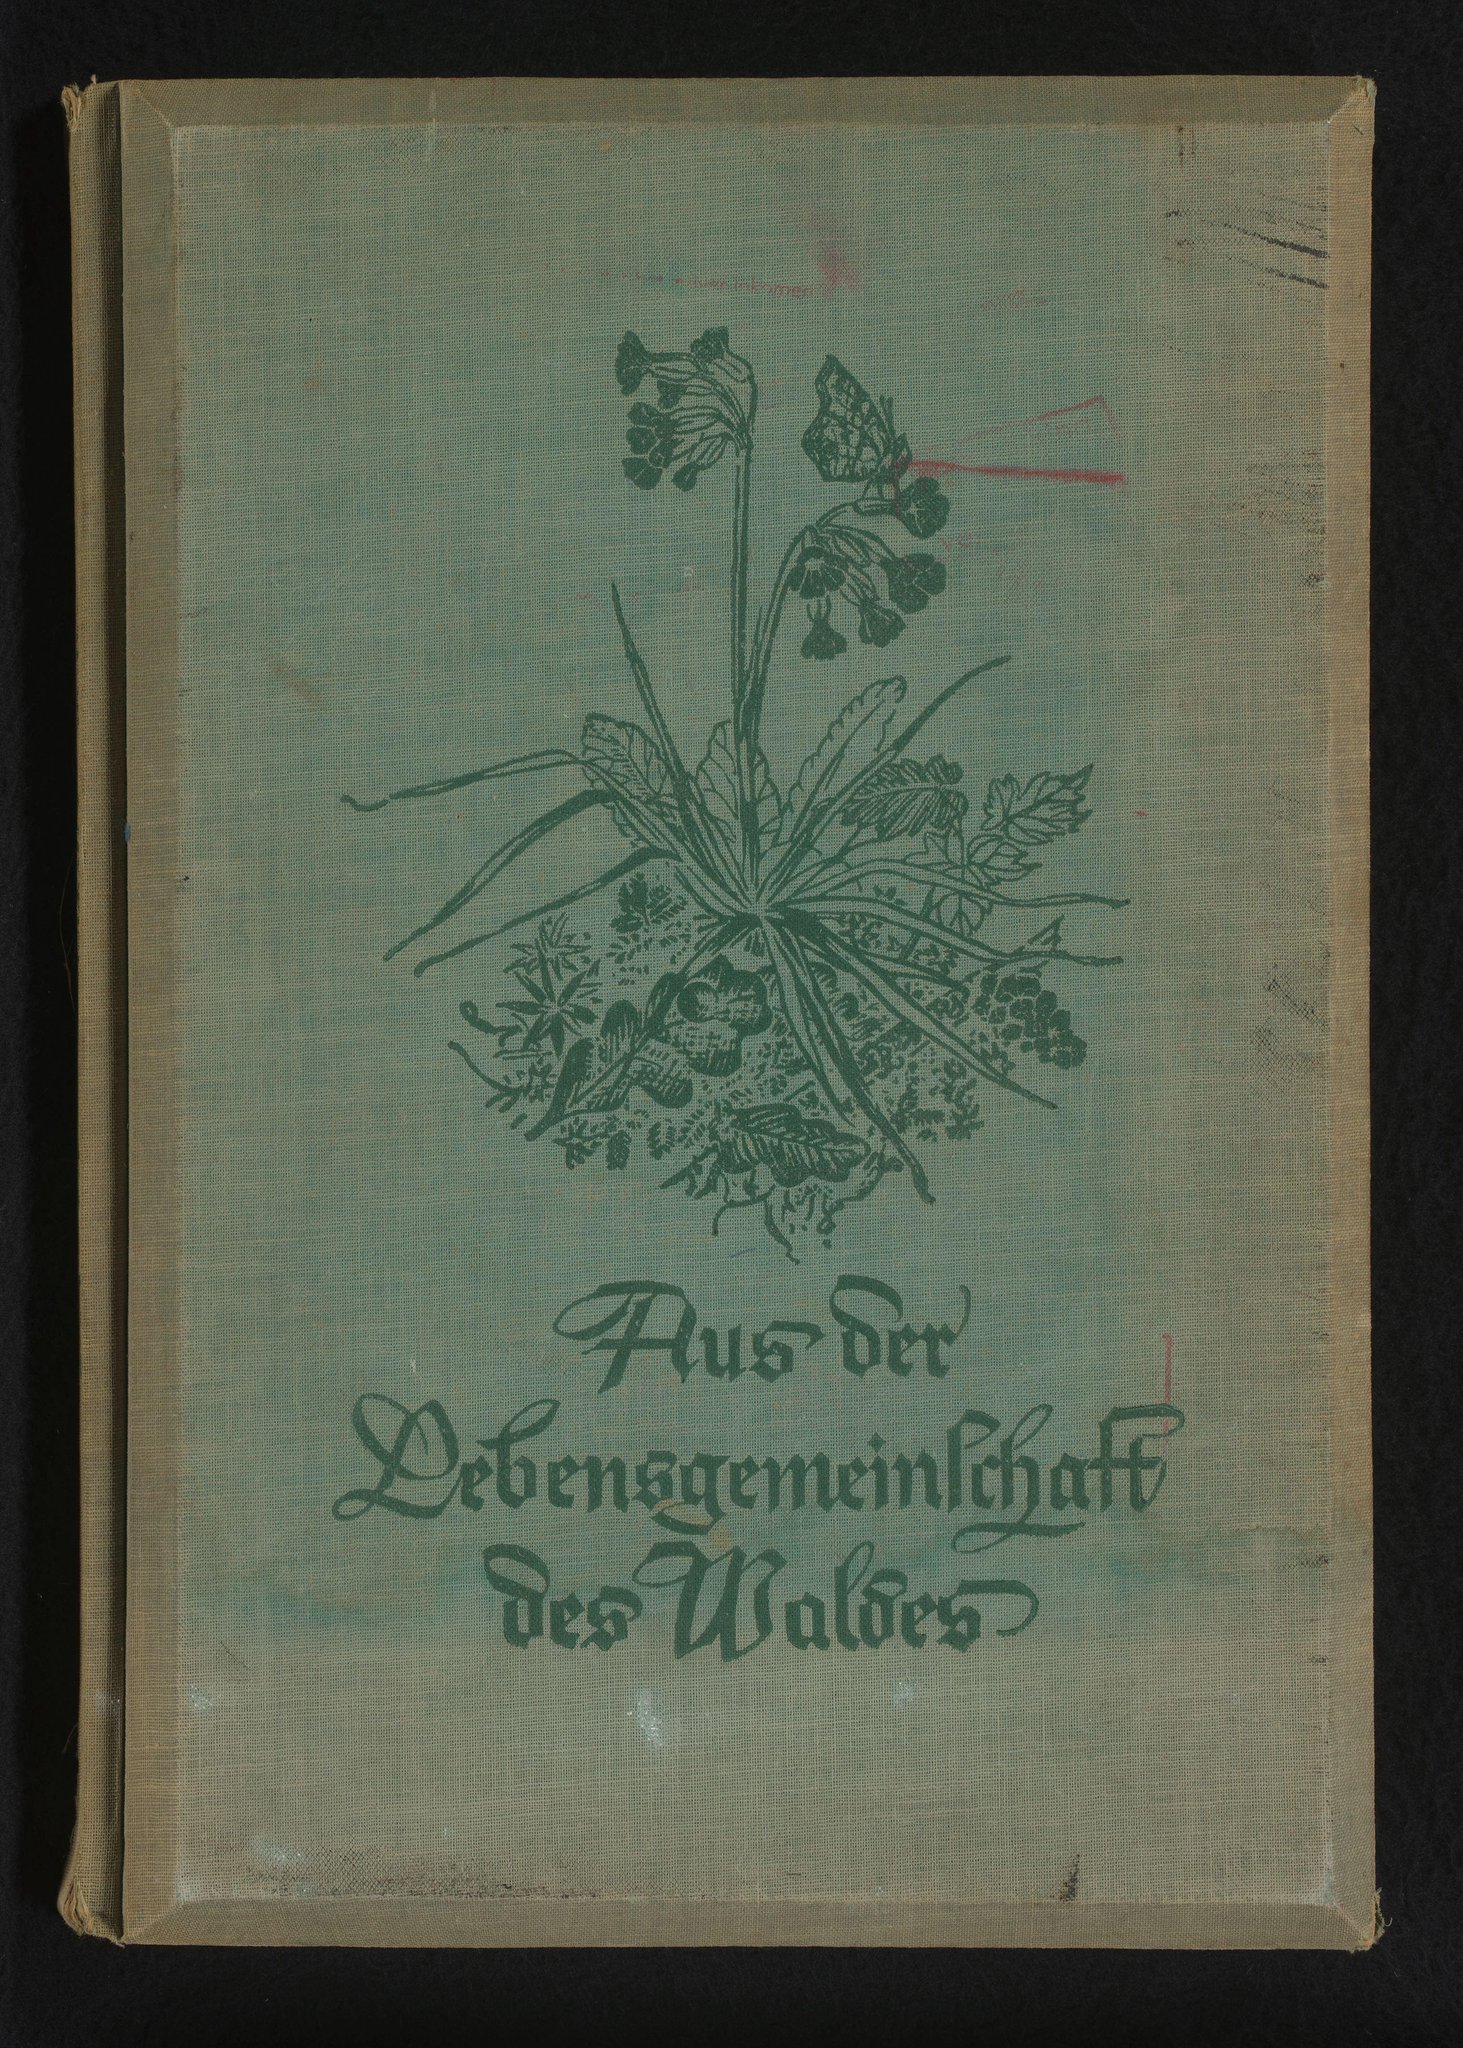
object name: book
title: Aus der Lebensgemeinschaft des Waldes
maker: kurt dieterich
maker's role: fotograaf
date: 1939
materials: cardboard, linen, metal, paper, photographic support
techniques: decorated paper, gelatin silver print, printing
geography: germany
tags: plants; vegetation, forest, wood, bush, shrubs ~ forest, germany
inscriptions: annotation: ‘61/a 10,-/ mit [...] pfotos./ Raumbild [....]/ fu[..]t.’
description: Boek met in de band vijf stapels stereofoto's en een stereoscoop. Afgebeeld zijn bomen en planten in de Duitse wouden. Verder bevat het boek enkele platen in autotypie die tussen de tekstbladen zijn gebonden, waarop landschappen en bossen te zien zijn. In de tekst wordt een uitgebreide uitleg gegeven bij iedere stereofoto. Achterin het boek bevindt zich een lijst met beschrijvingen van de 150 stereofoto's.